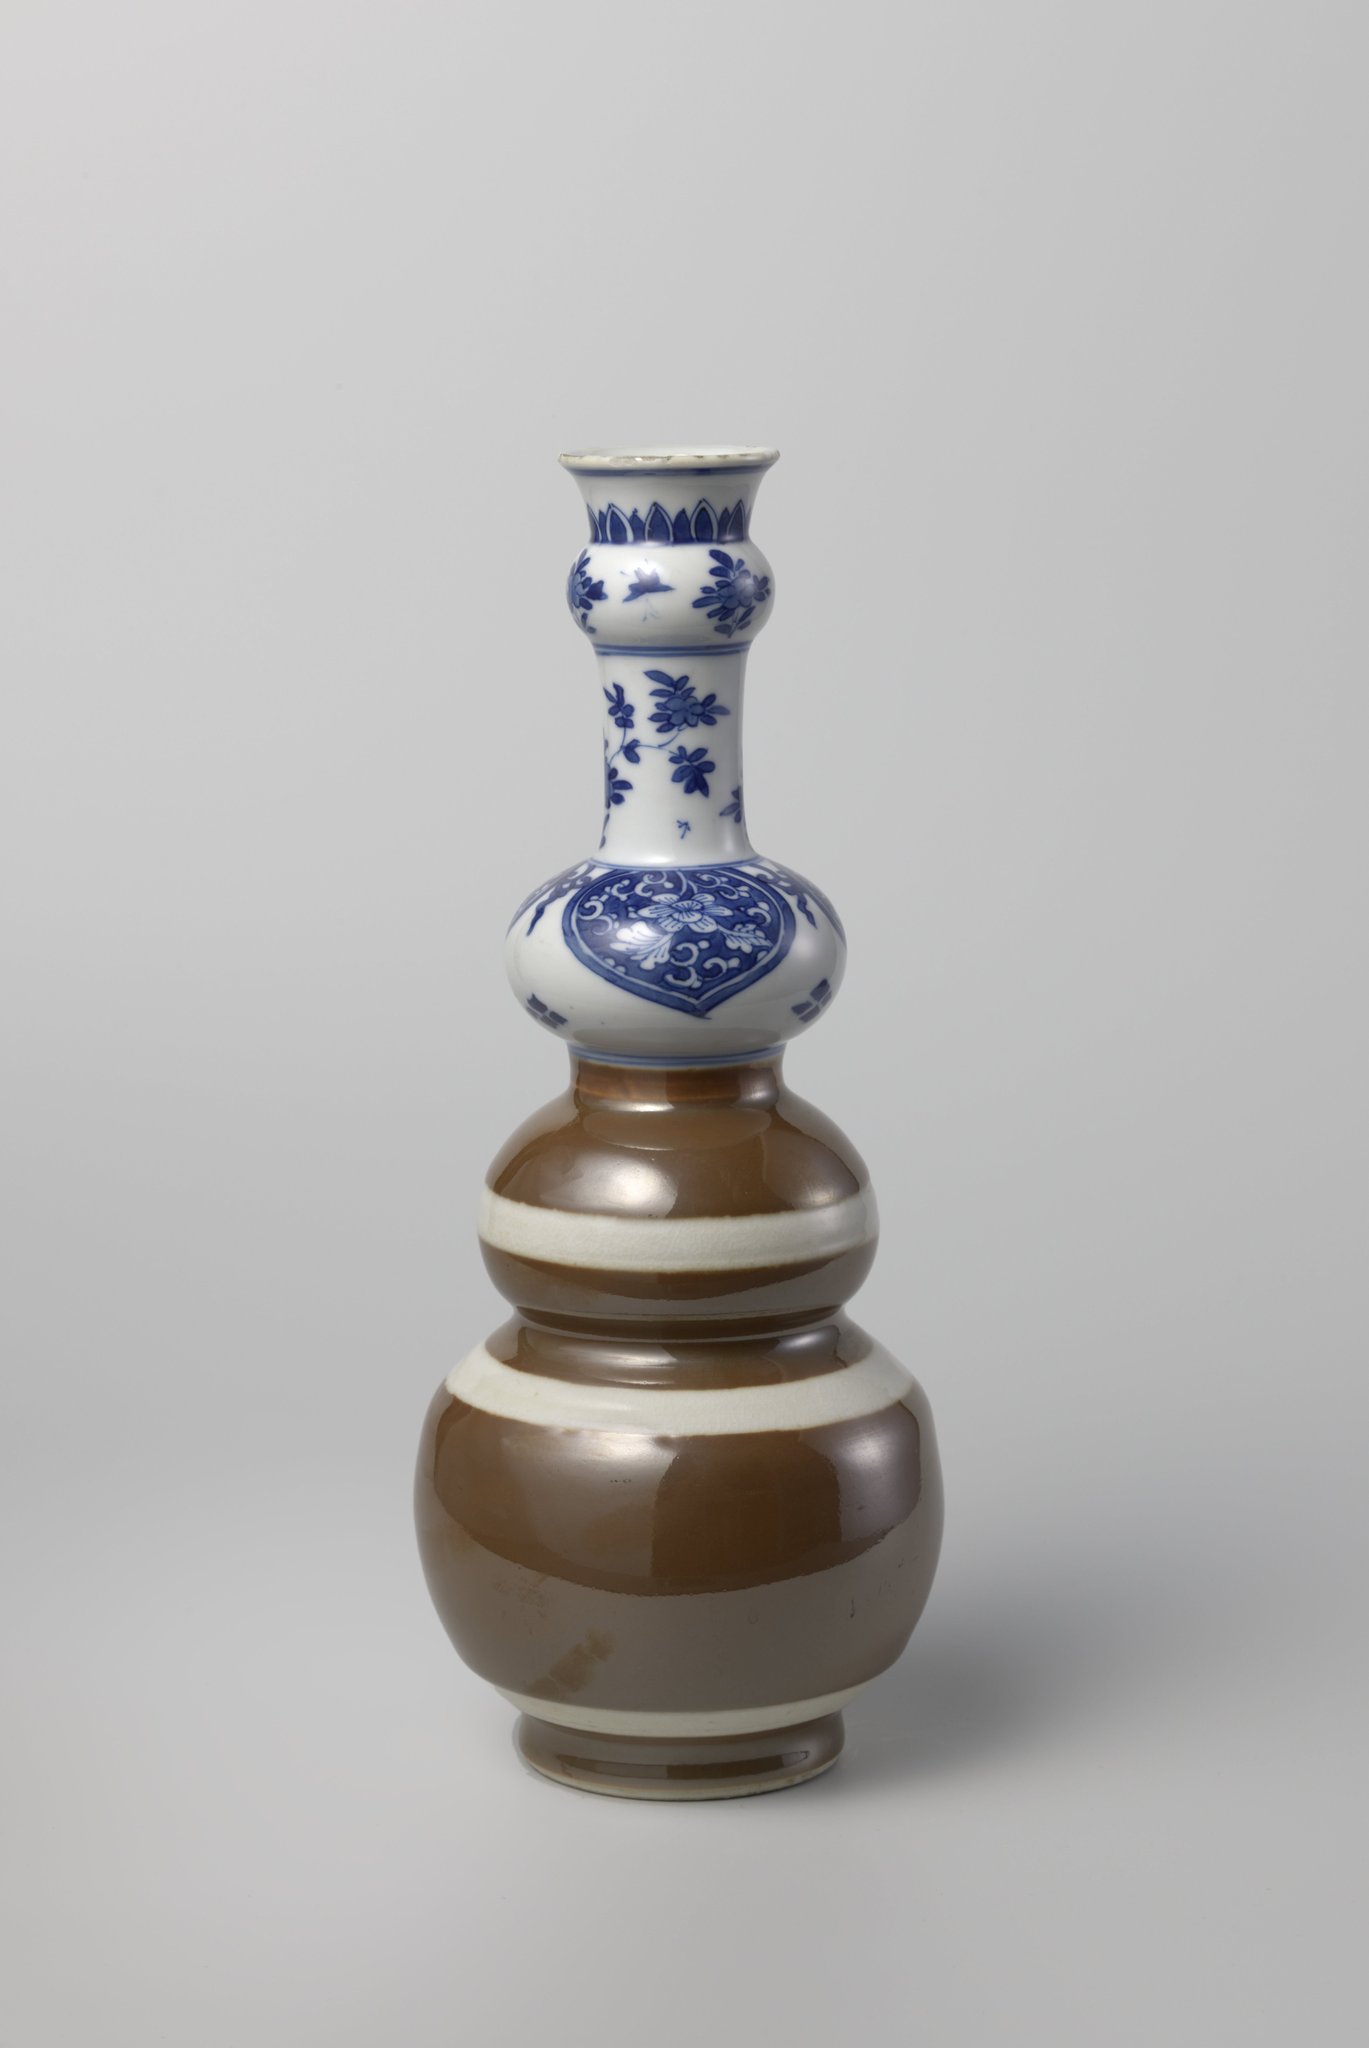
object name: vase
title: Triple gourd-shaped bottle with brown glaze and flower scrolls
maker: Anonymous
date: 1675-1699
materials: cobalt, glaze, paint, porcelain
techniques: firing, turning, vitrification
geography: china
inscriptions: label: ‘Vrienden der Aziatische Kunst’